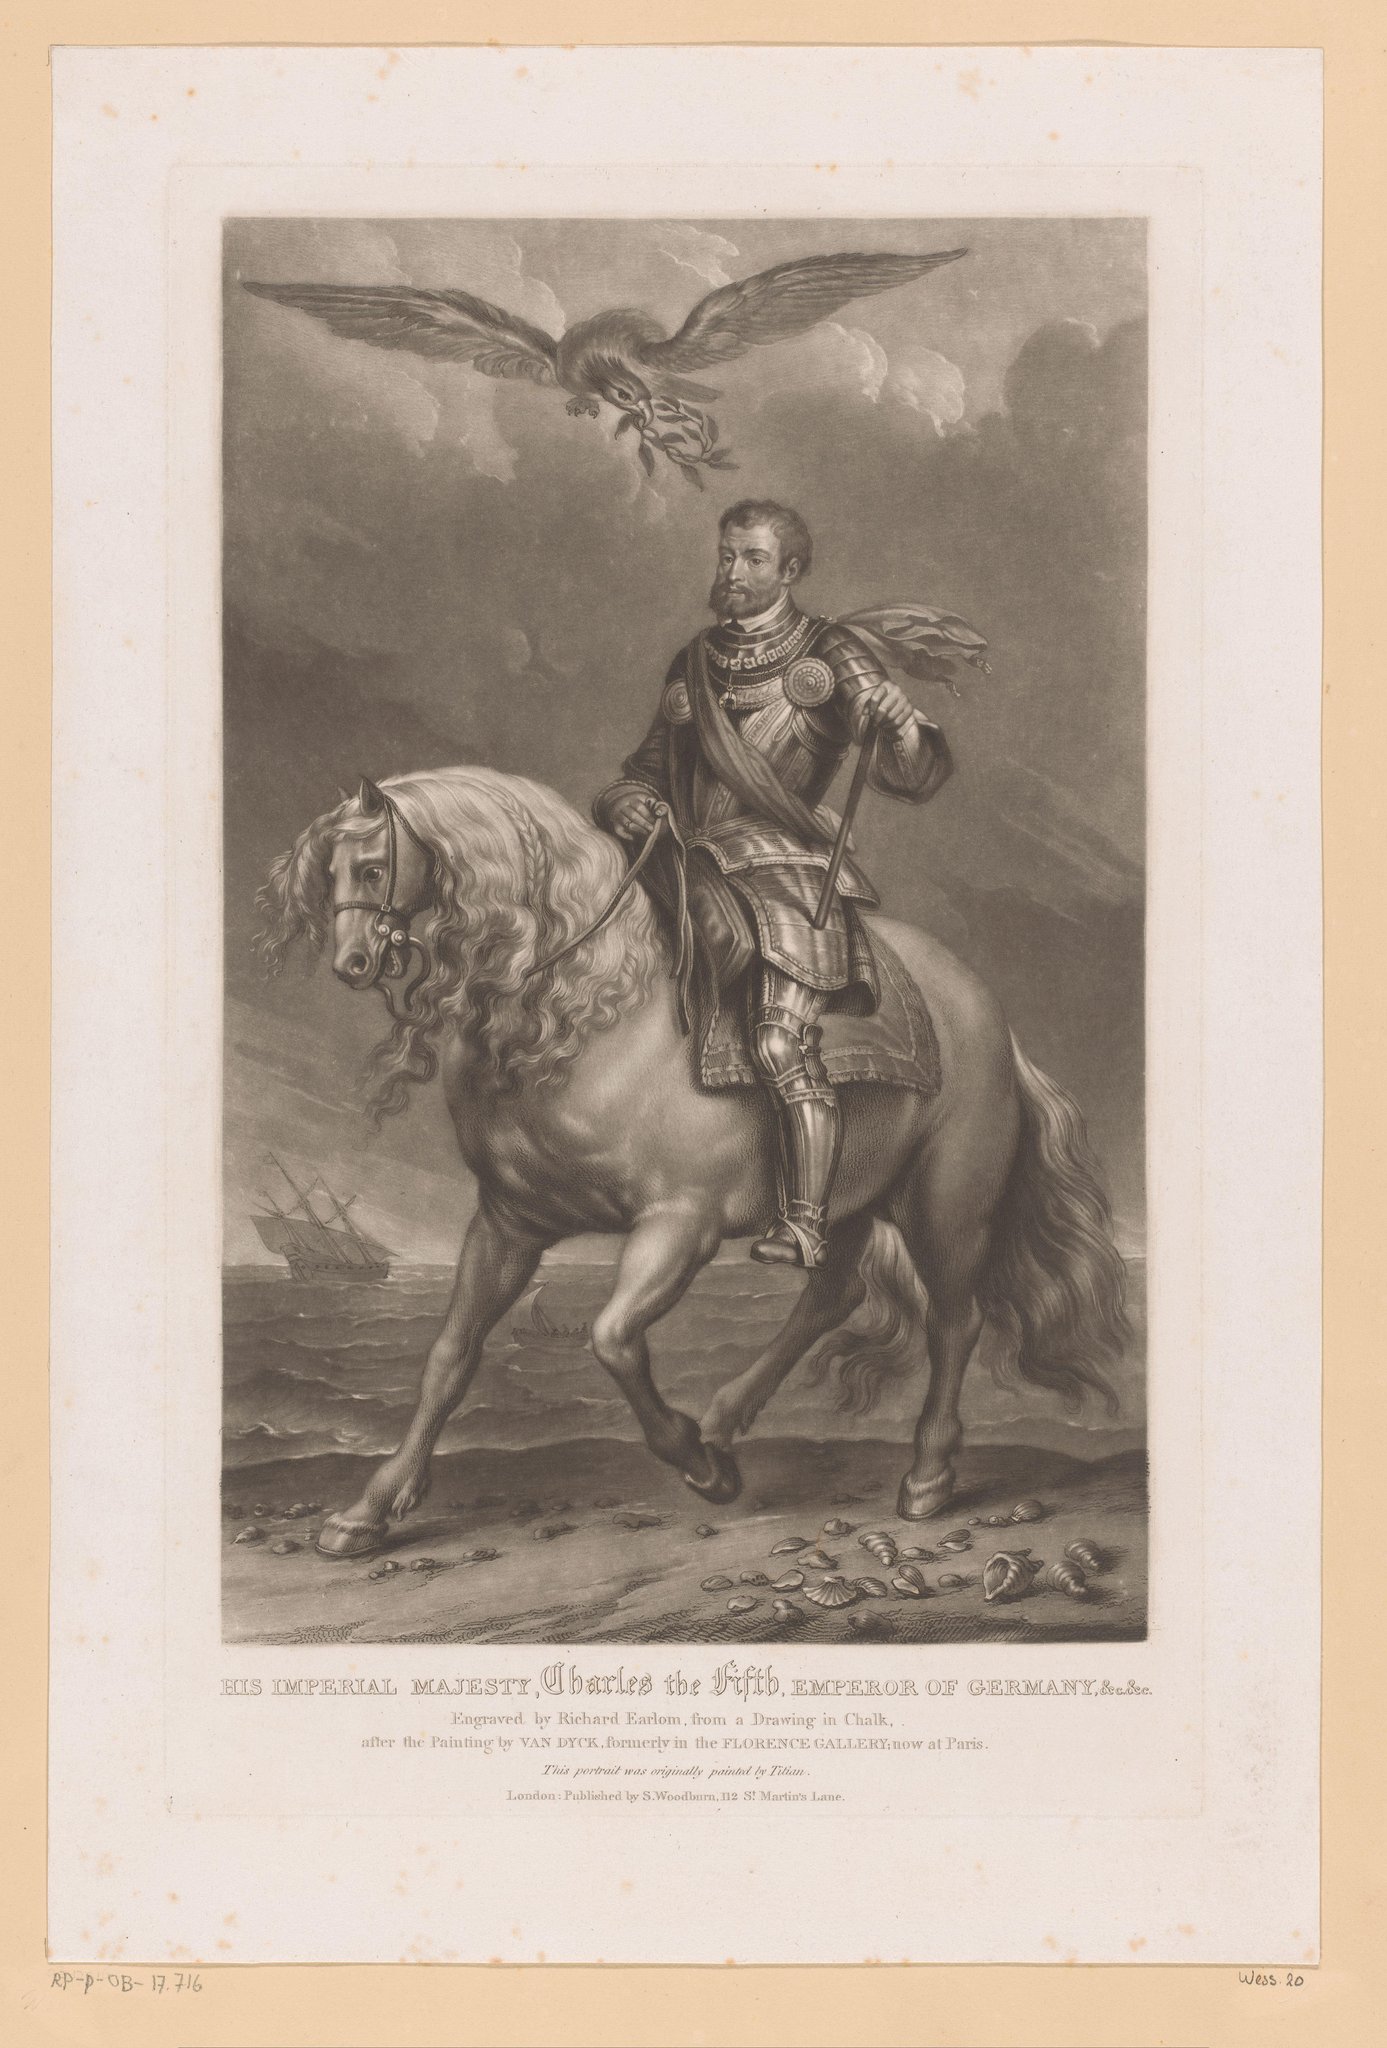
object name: print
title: Ruiterportret van keizer Karel V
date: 1760-1822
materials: paper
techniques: etching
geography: london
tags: ghent, charles v (holy roman emperor and king of spain), equestrian state-portrait, historical persons, emperor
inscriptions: collector's mark: Lugt 12